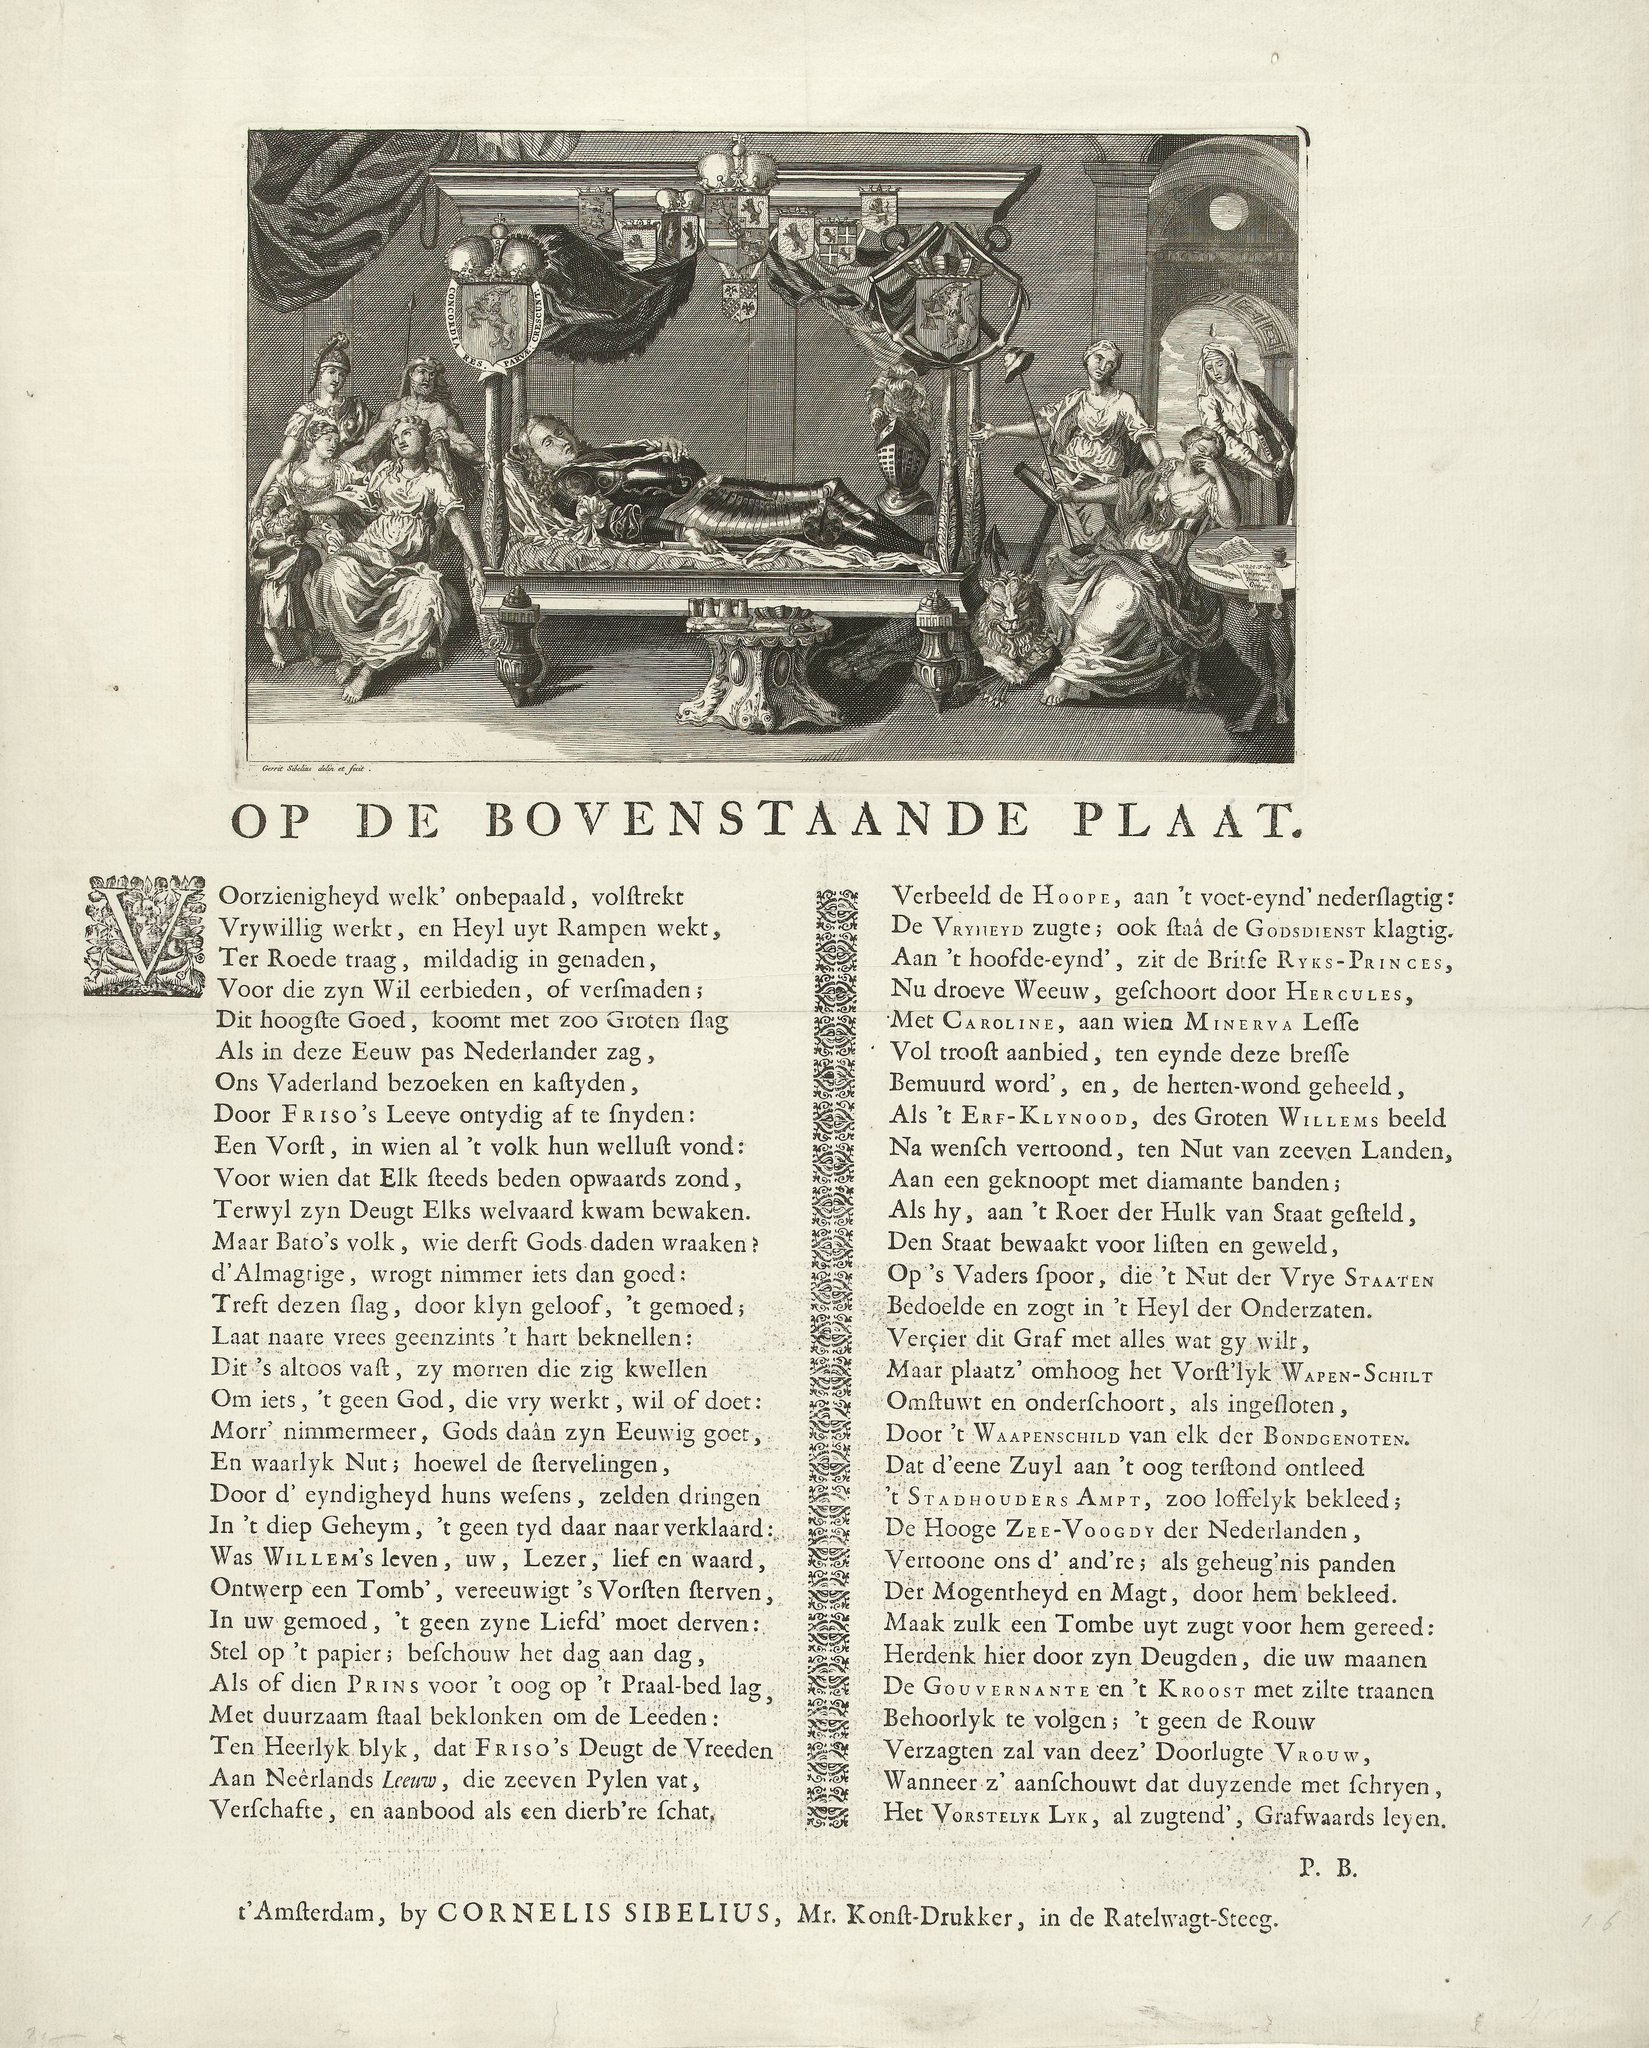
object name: print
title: Allegorisch praalbed van prins Willem IV, 1751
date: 1751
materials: paper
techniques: engraving, etching, letterpress printing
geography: amsterdam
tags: the hague, william v (prince of orange), carolina (prinses van oranje-nassau), willem iv (prins van oranje-nassau), anna van hannover, lying in state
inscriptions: collector's mark: Lugt 2228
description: Het praalbed van de op 22 oktober overleden prins Willem IV en waarop hij gedurende de maanden november en december van het jaar 1751 opgebaard heeft gelegen. Aan het hoofdeinde van het bed de rouwende weduwe met dochter prinses Caroline en zoon prins Willem V vergezeld door allegorische figuren. Het bed versierd met de wapens van de zeven provincies, de Generaliteit en de Admiraliteit. Op het blad onder de plaat een vers in twee kolommen met een versierde initiaal V.